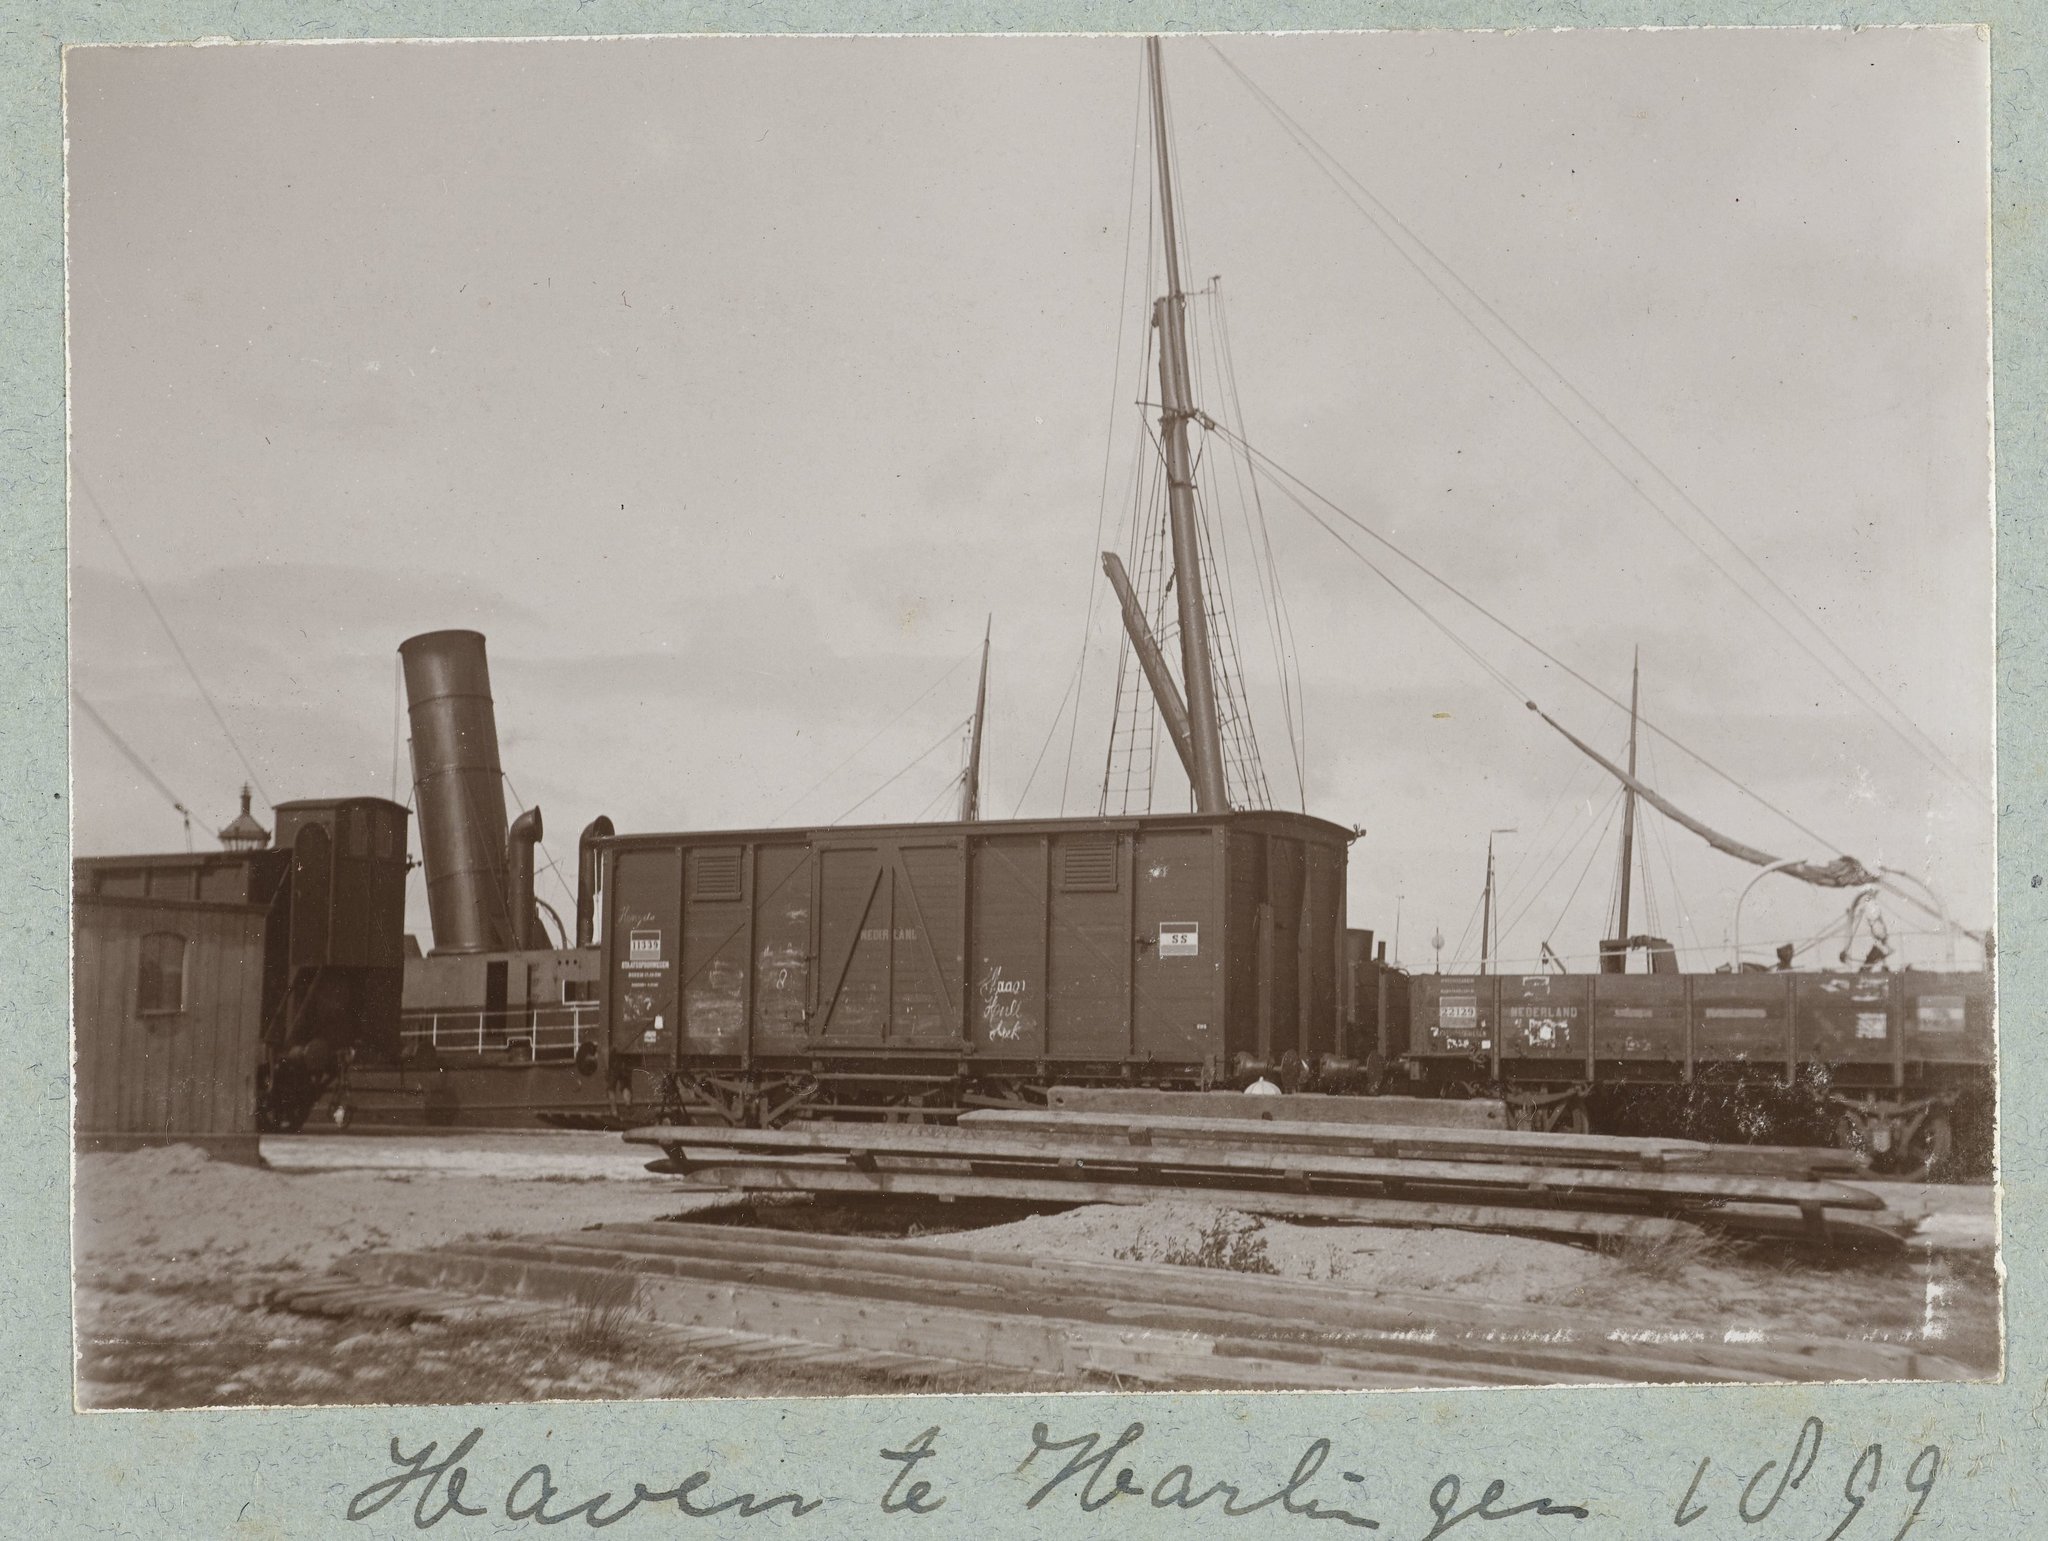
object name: photograph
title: Treinwagon in haven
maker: frits freerks fontein fz.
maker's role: fotograaf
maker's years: 1882-1928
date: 1899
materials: cardboard, paper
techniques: gelatin silver print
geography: netherlands